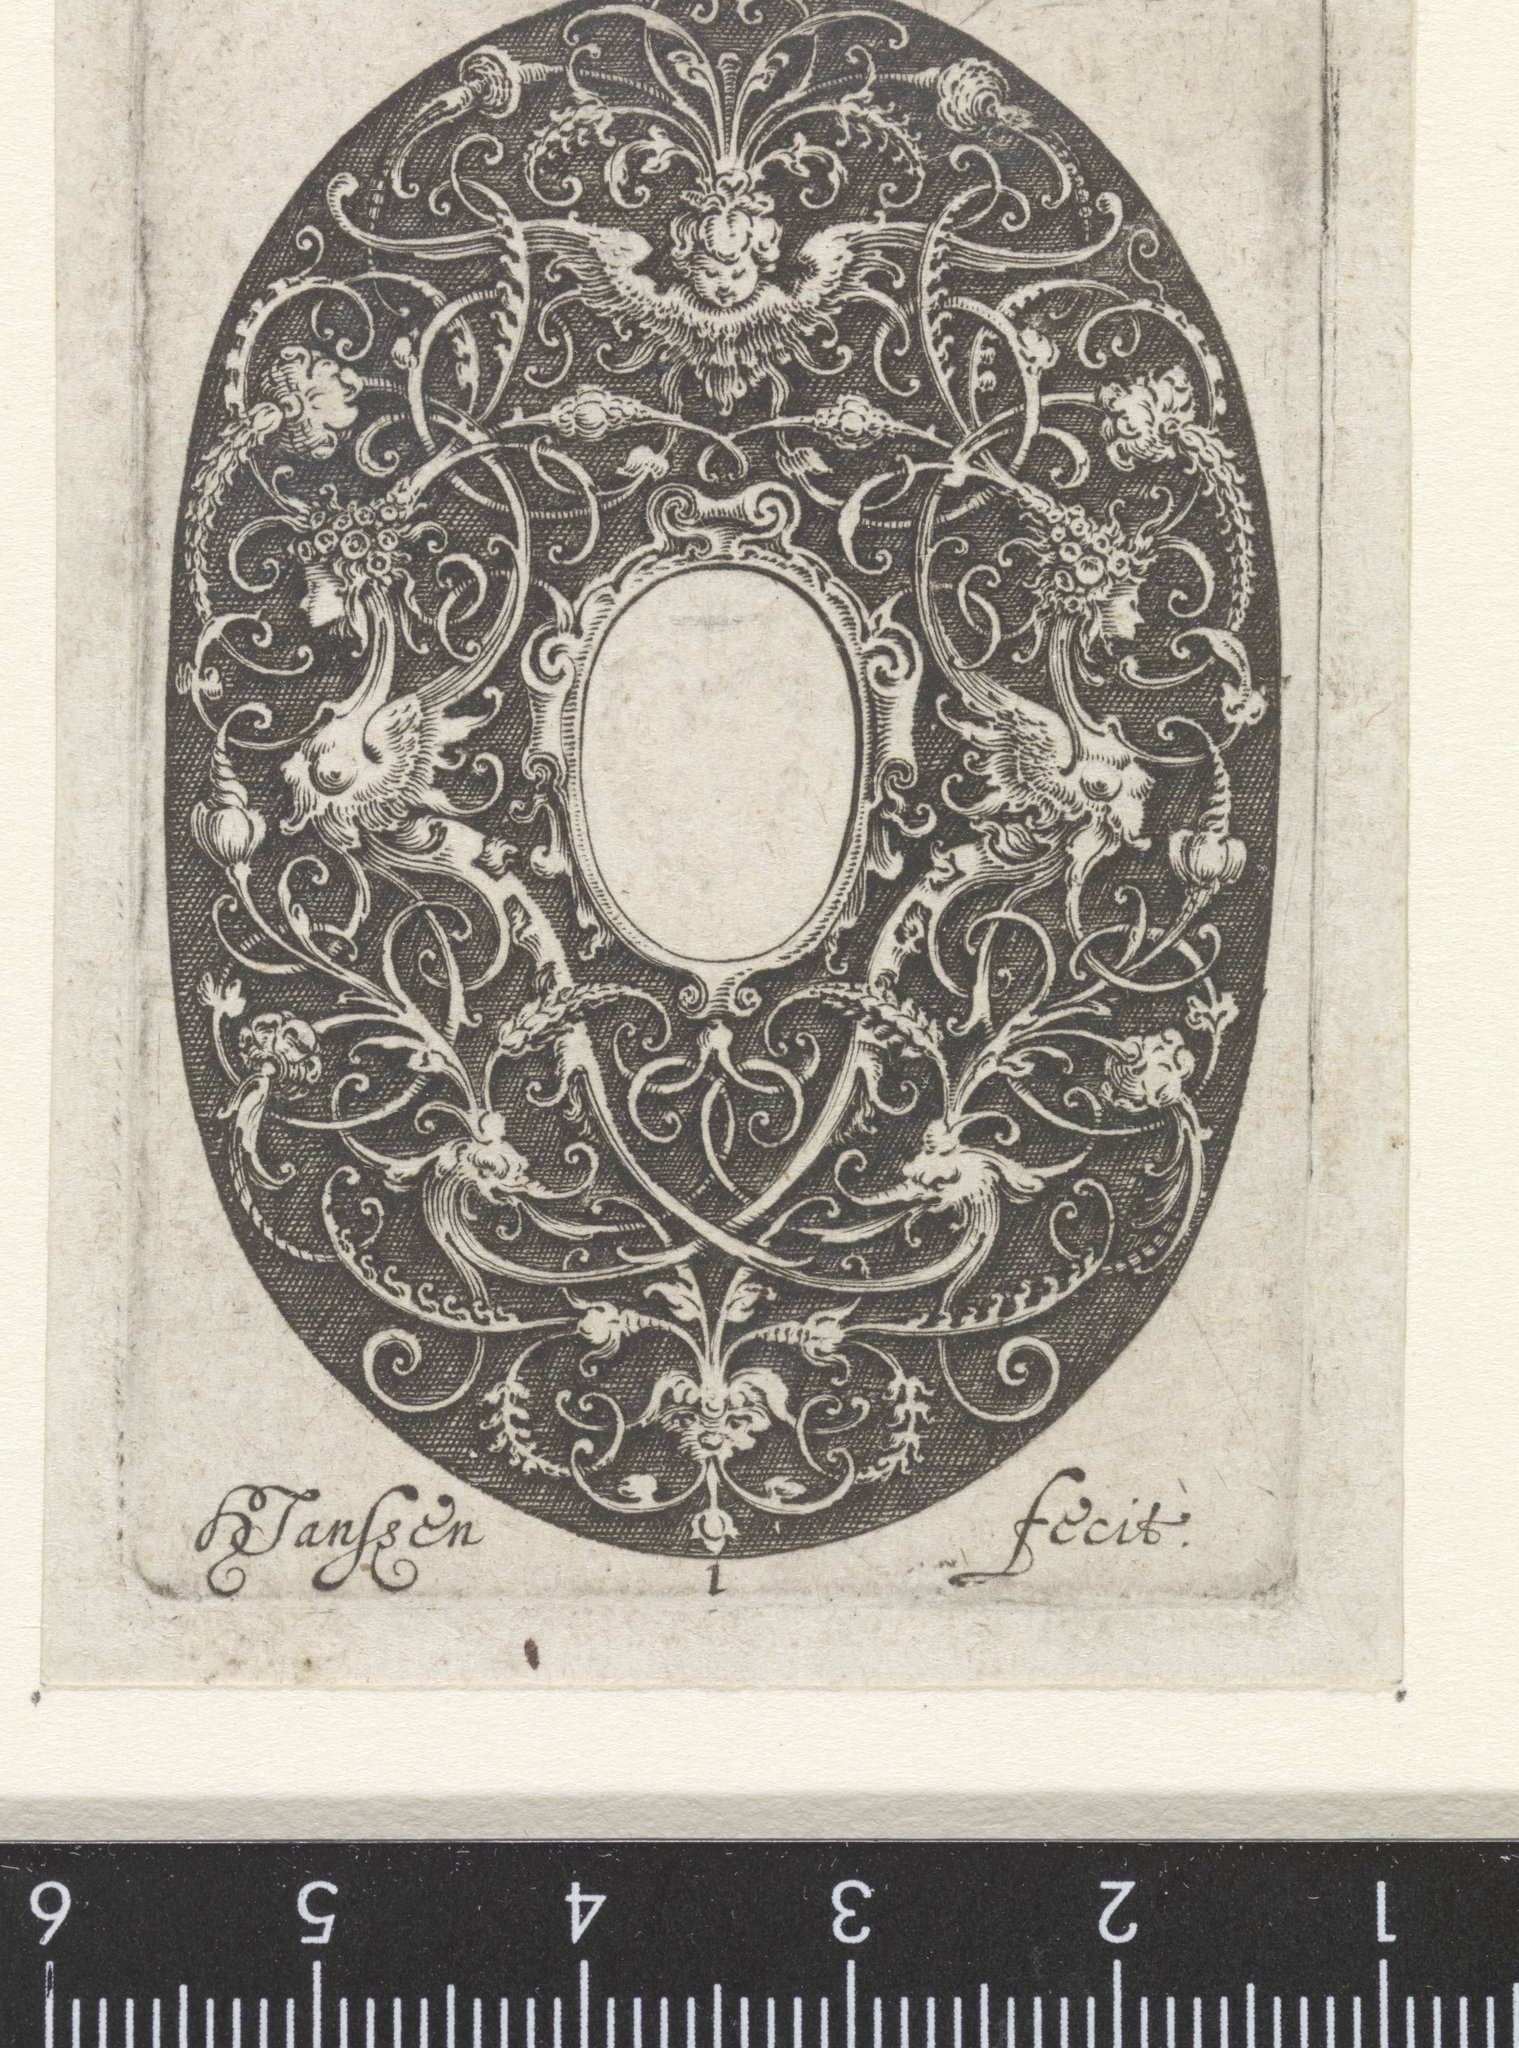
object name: ornament print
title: Kleine ovalen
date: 1615-1630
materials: paper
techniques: etching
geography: amsterdam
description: In de ranken zijn twee sfinxen en een cherubijn verwerkt.